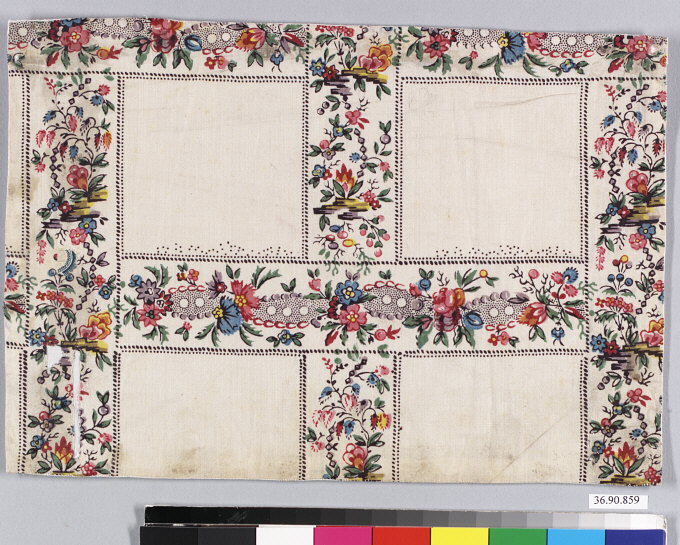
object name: piece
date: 1801-1900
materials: cotton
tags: flowers,leaves